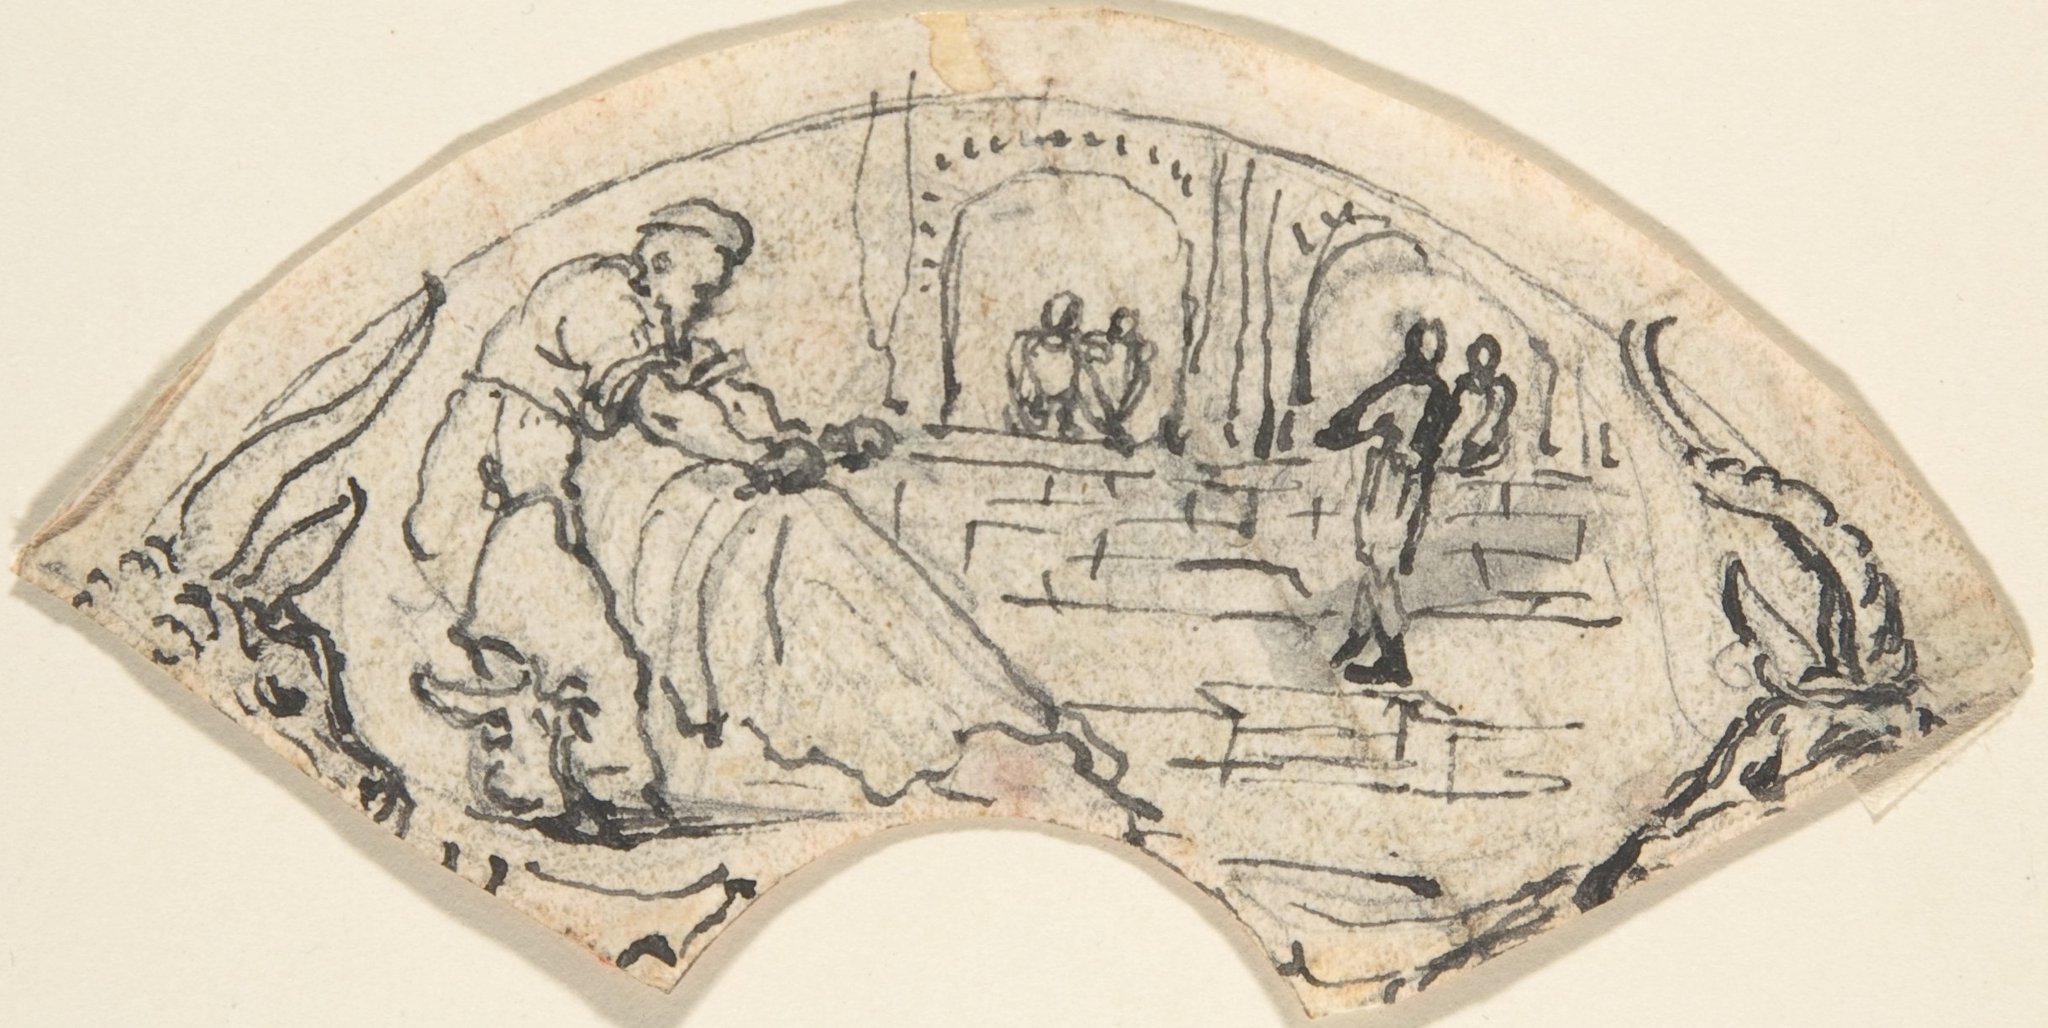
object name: drawing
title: Design for a Cup(?) with a Man Putting up a Net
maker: anonymous, german, 19th century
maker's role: artist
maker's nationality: german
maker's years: 1800-1899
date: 1801-1900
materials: chalk, ink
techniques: incising, pen, transfer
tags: human figures,working